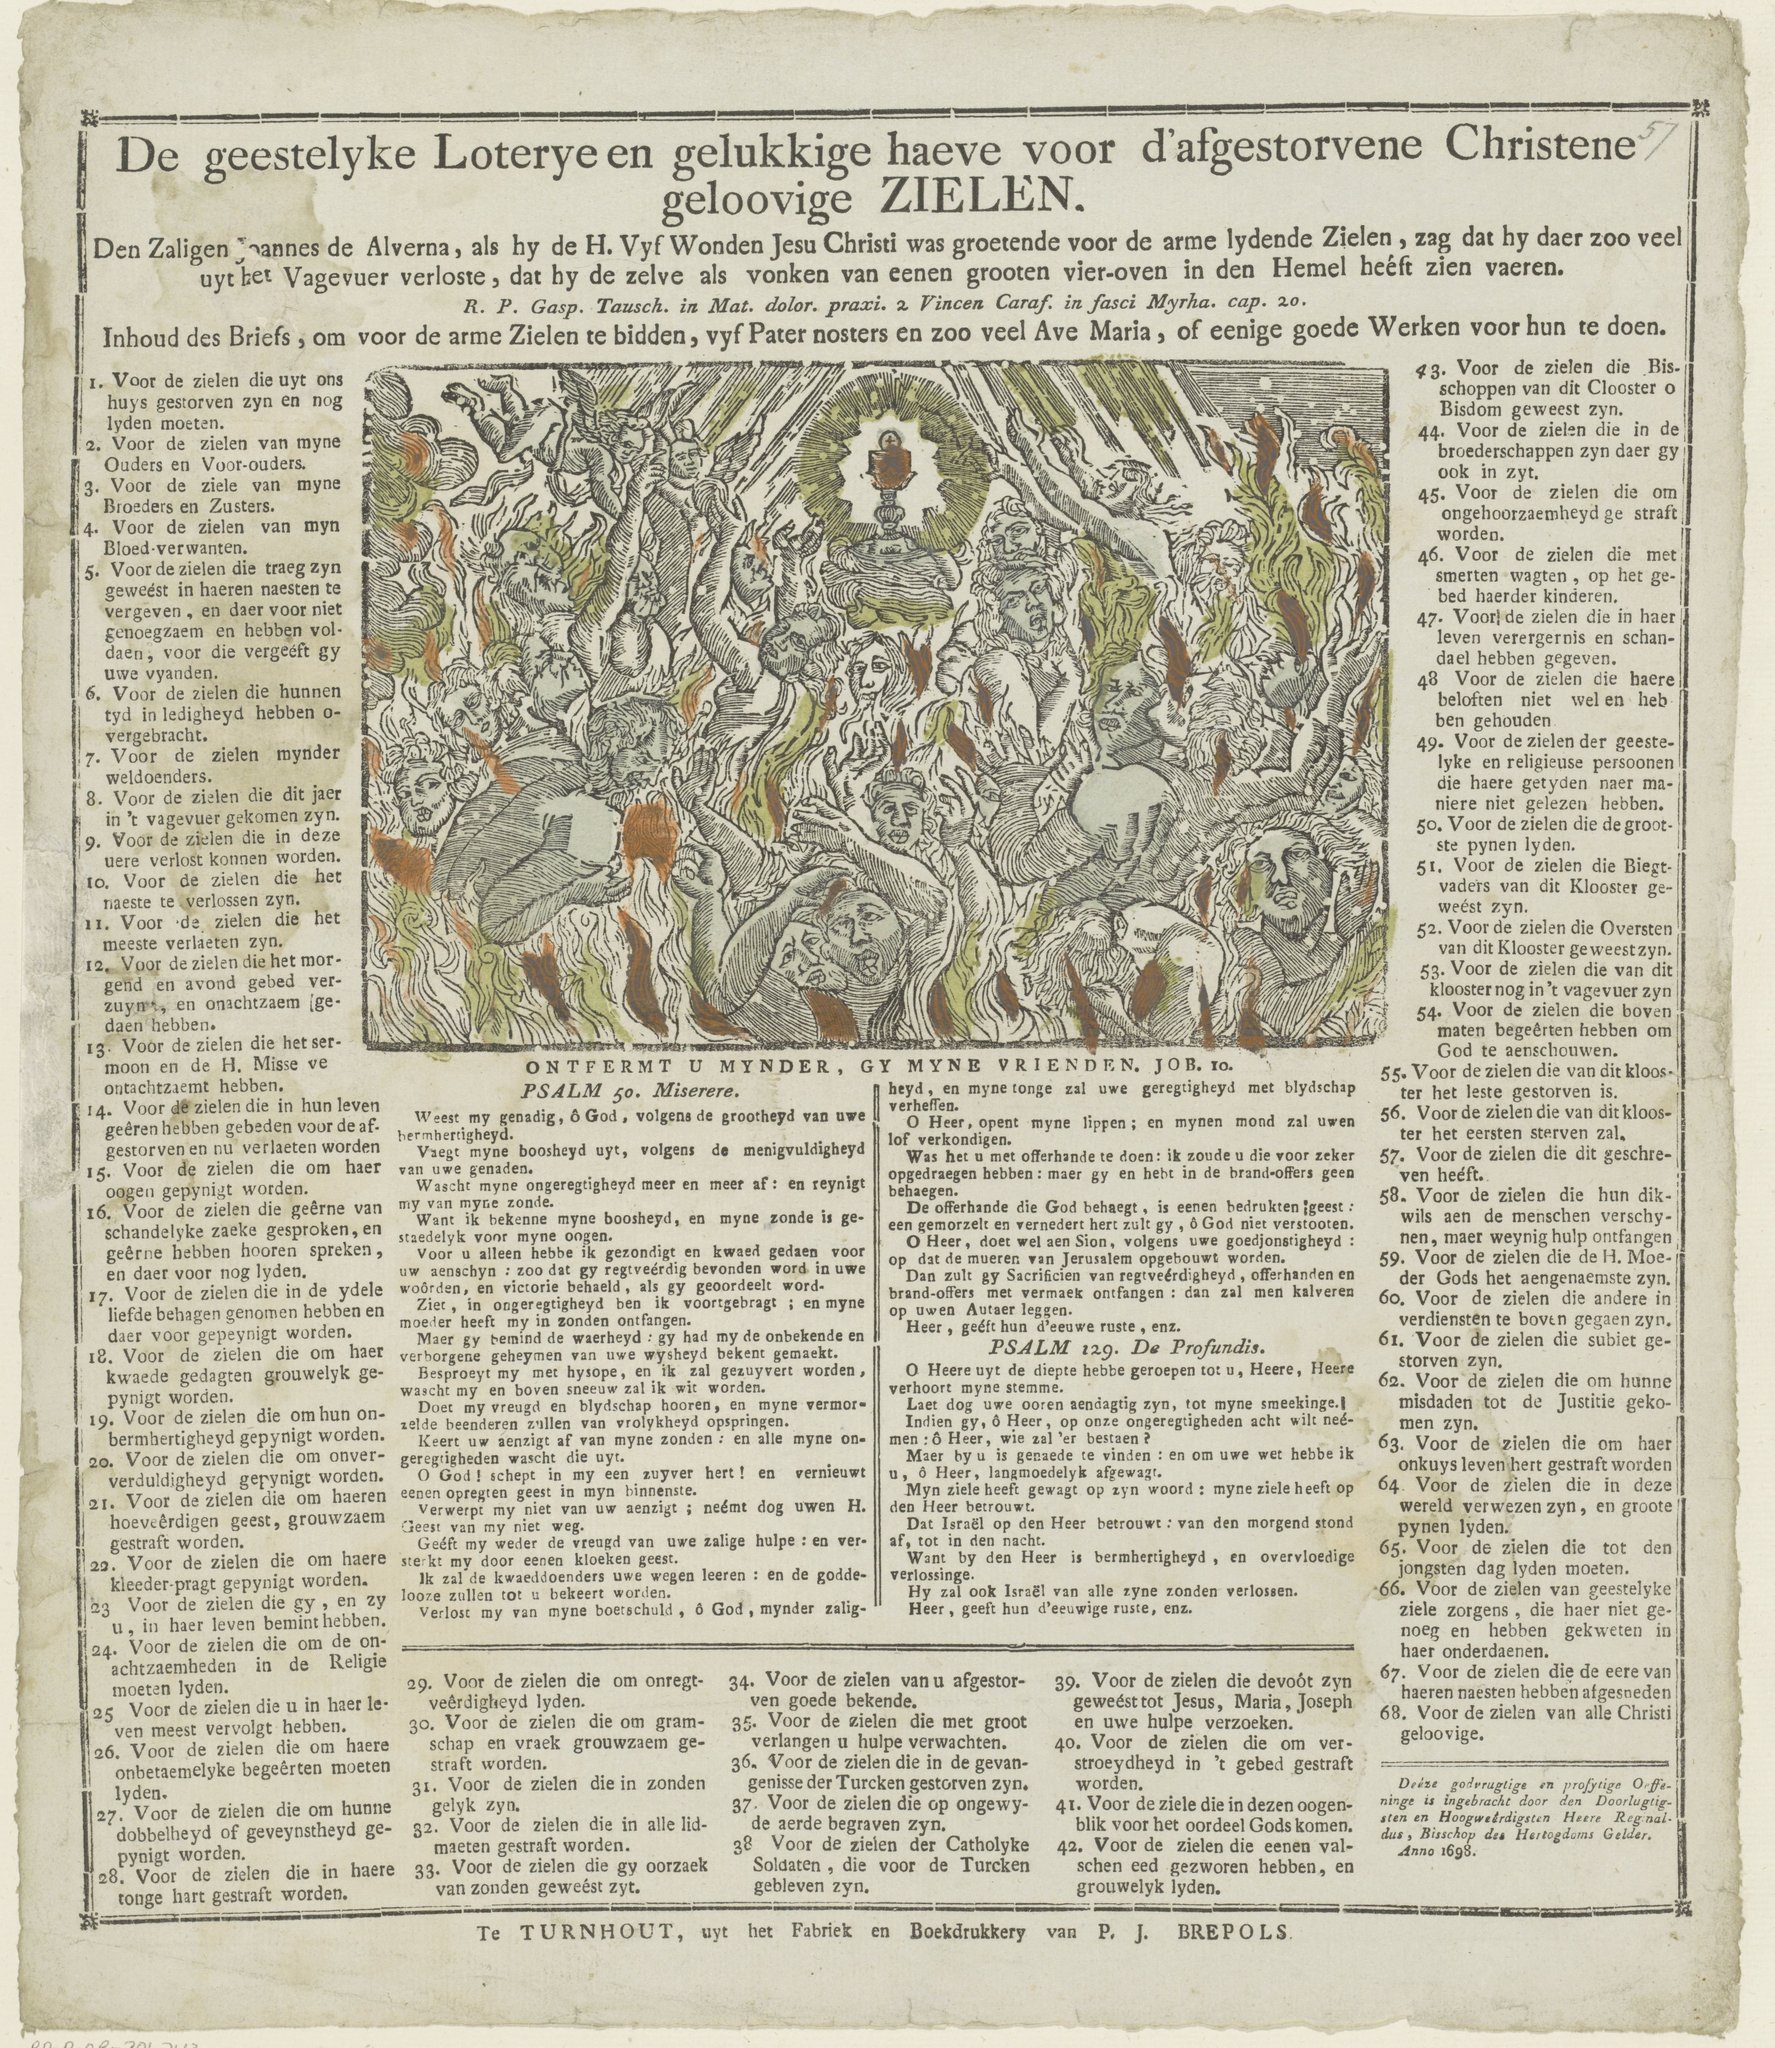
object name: print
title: De geestelyke loterye en gelukkige haeve voor d'afgestorvene christene / geloovige zielen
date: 1800-1833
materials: paper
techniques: colour, letterpress printing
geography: turnhout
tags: purgatory, usually the souls praying or asking for intercession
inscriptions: collector's mark: Lugt 2760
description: Mensen in het vagevuur. Rondom tekst in boekdruk.